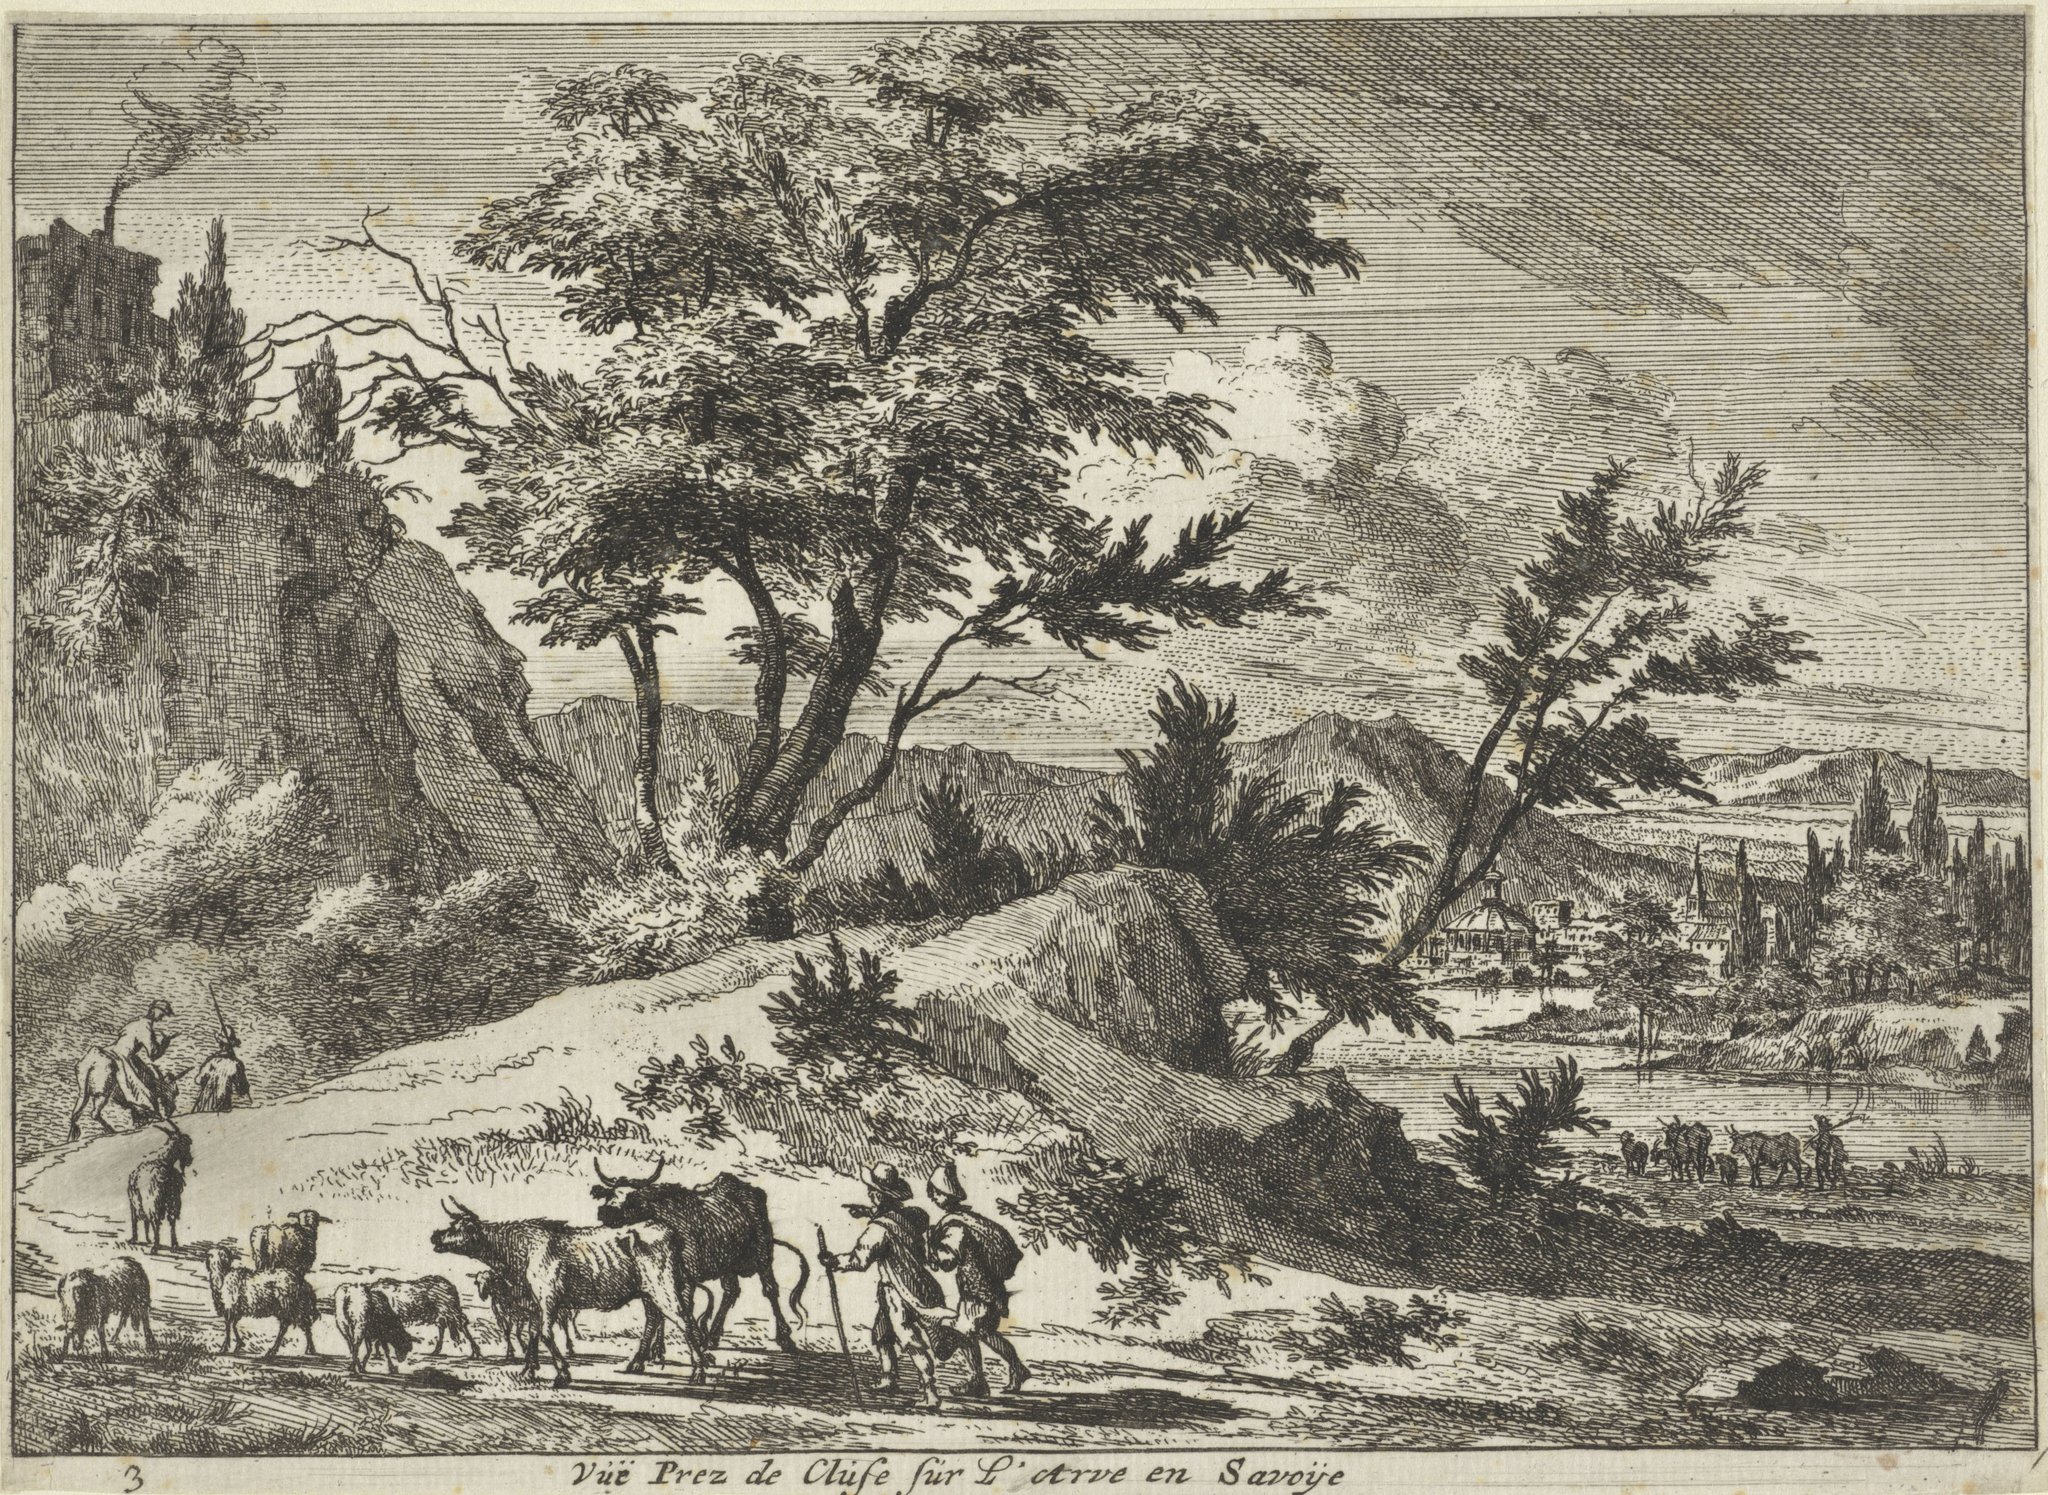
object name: print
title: Vue Prez de Cluse sur L´Arve en Savoije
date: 1688-1721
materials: paper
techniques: etching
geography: haarlem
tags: river, herding, herdsman, herdswoman, shepherd, shepherdess, cowherd, etc., herd, flock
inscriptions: collector's mark: Lugt 240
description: Herders met vee op een weg langs de rivier de Arve in Savoie. Op de achtergrond een stad.